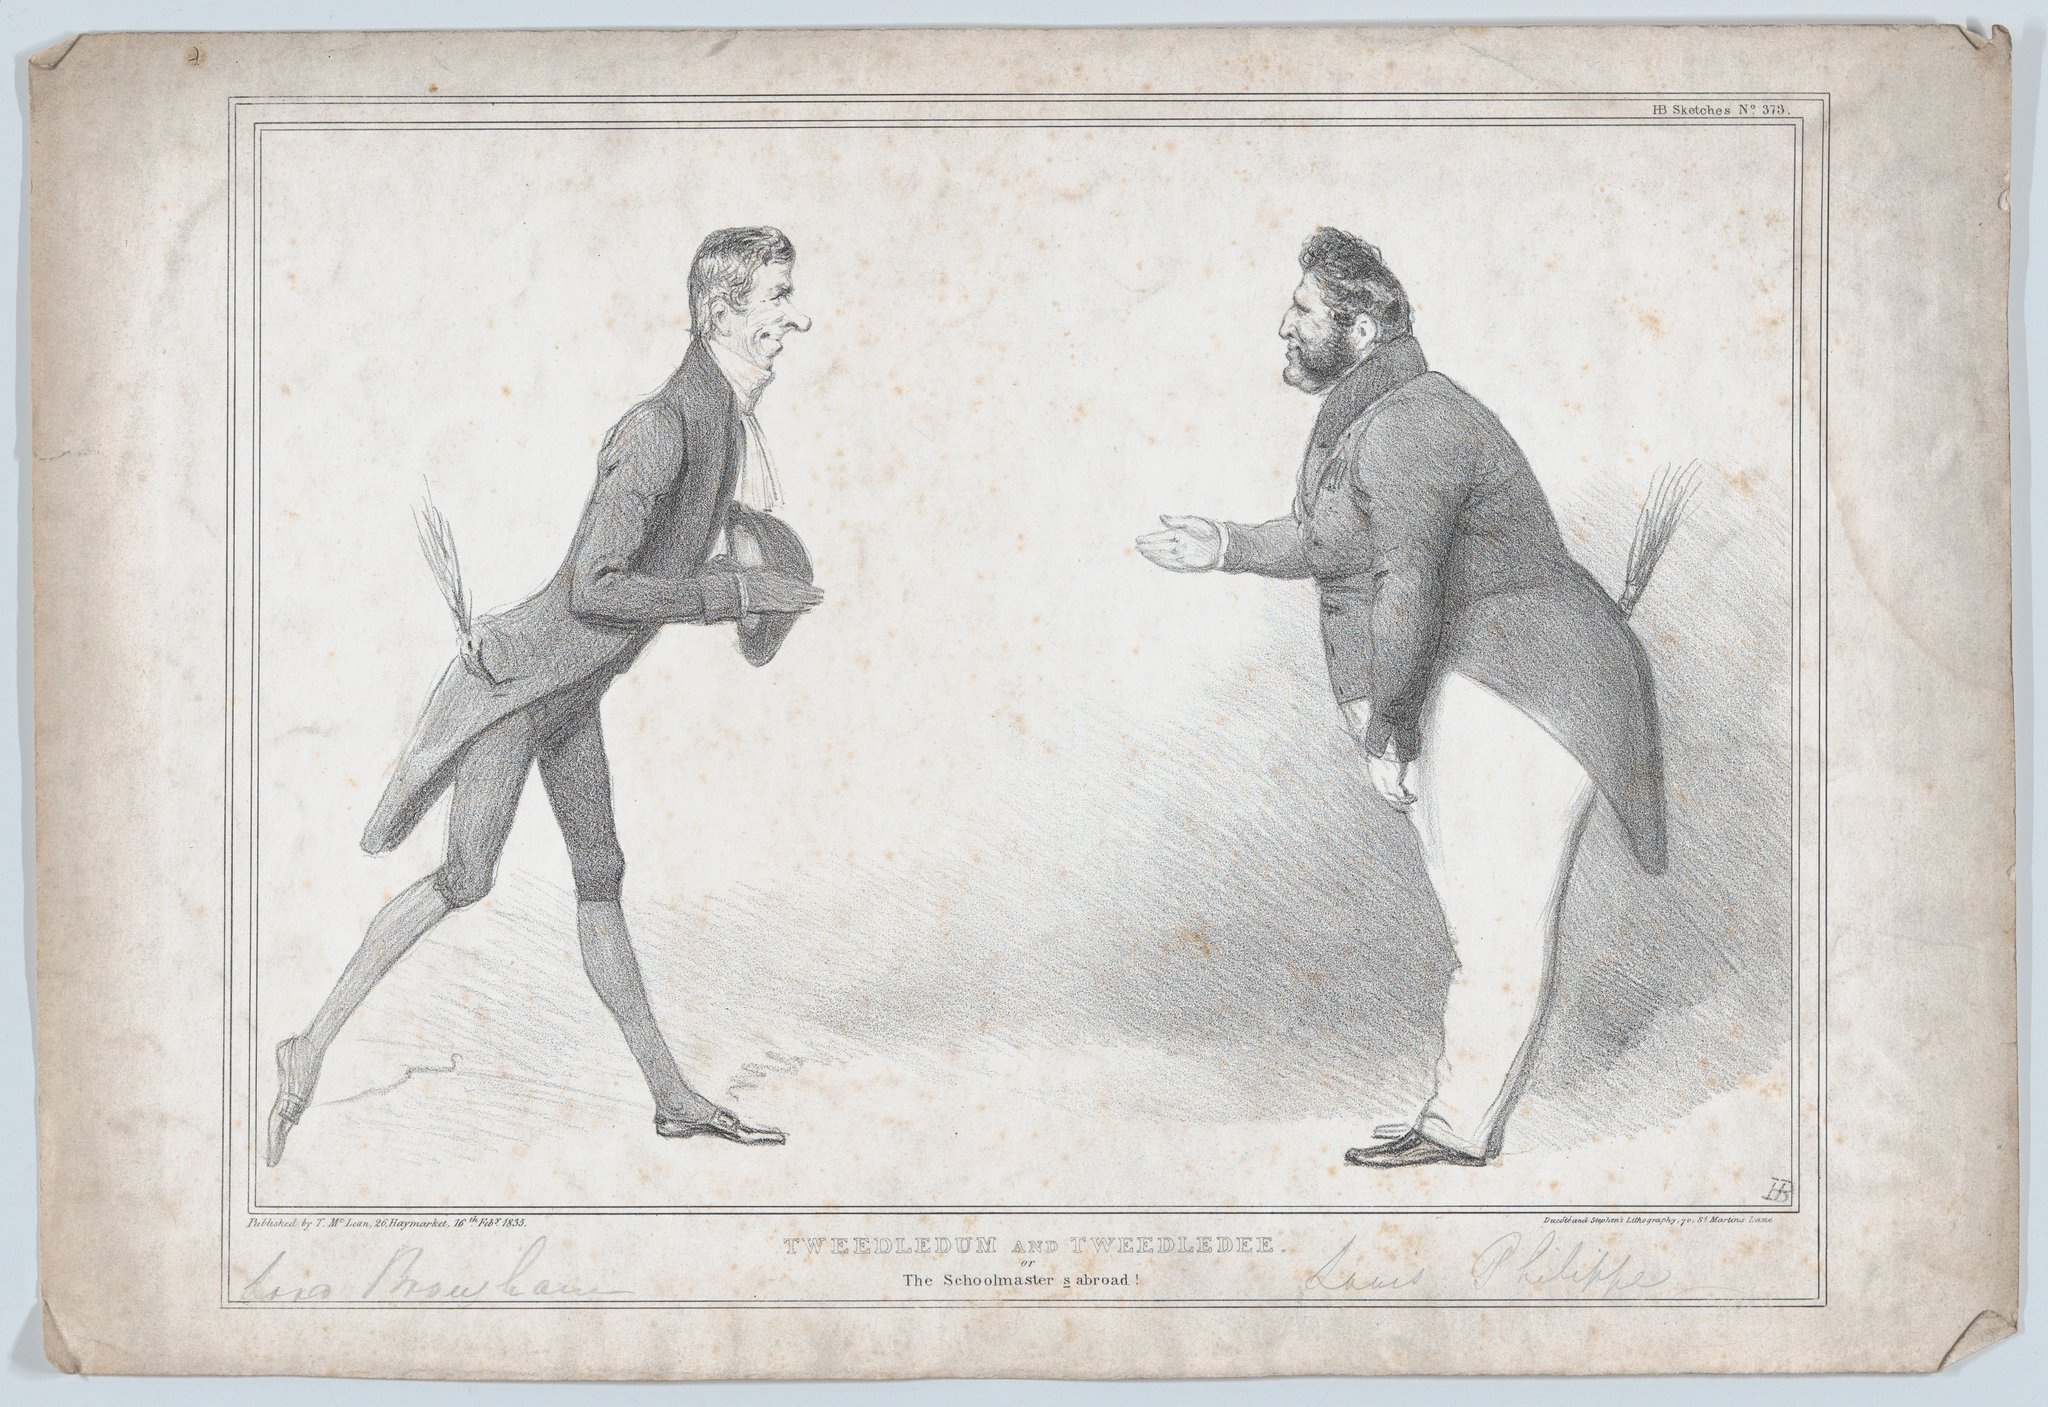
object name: print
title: Tweedledum and Tweedledee, or, The Schoolmaster [i]s abroad!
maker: john doyle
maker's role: artist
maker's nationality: irish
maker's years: 1797-1868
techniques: lithograph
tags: men